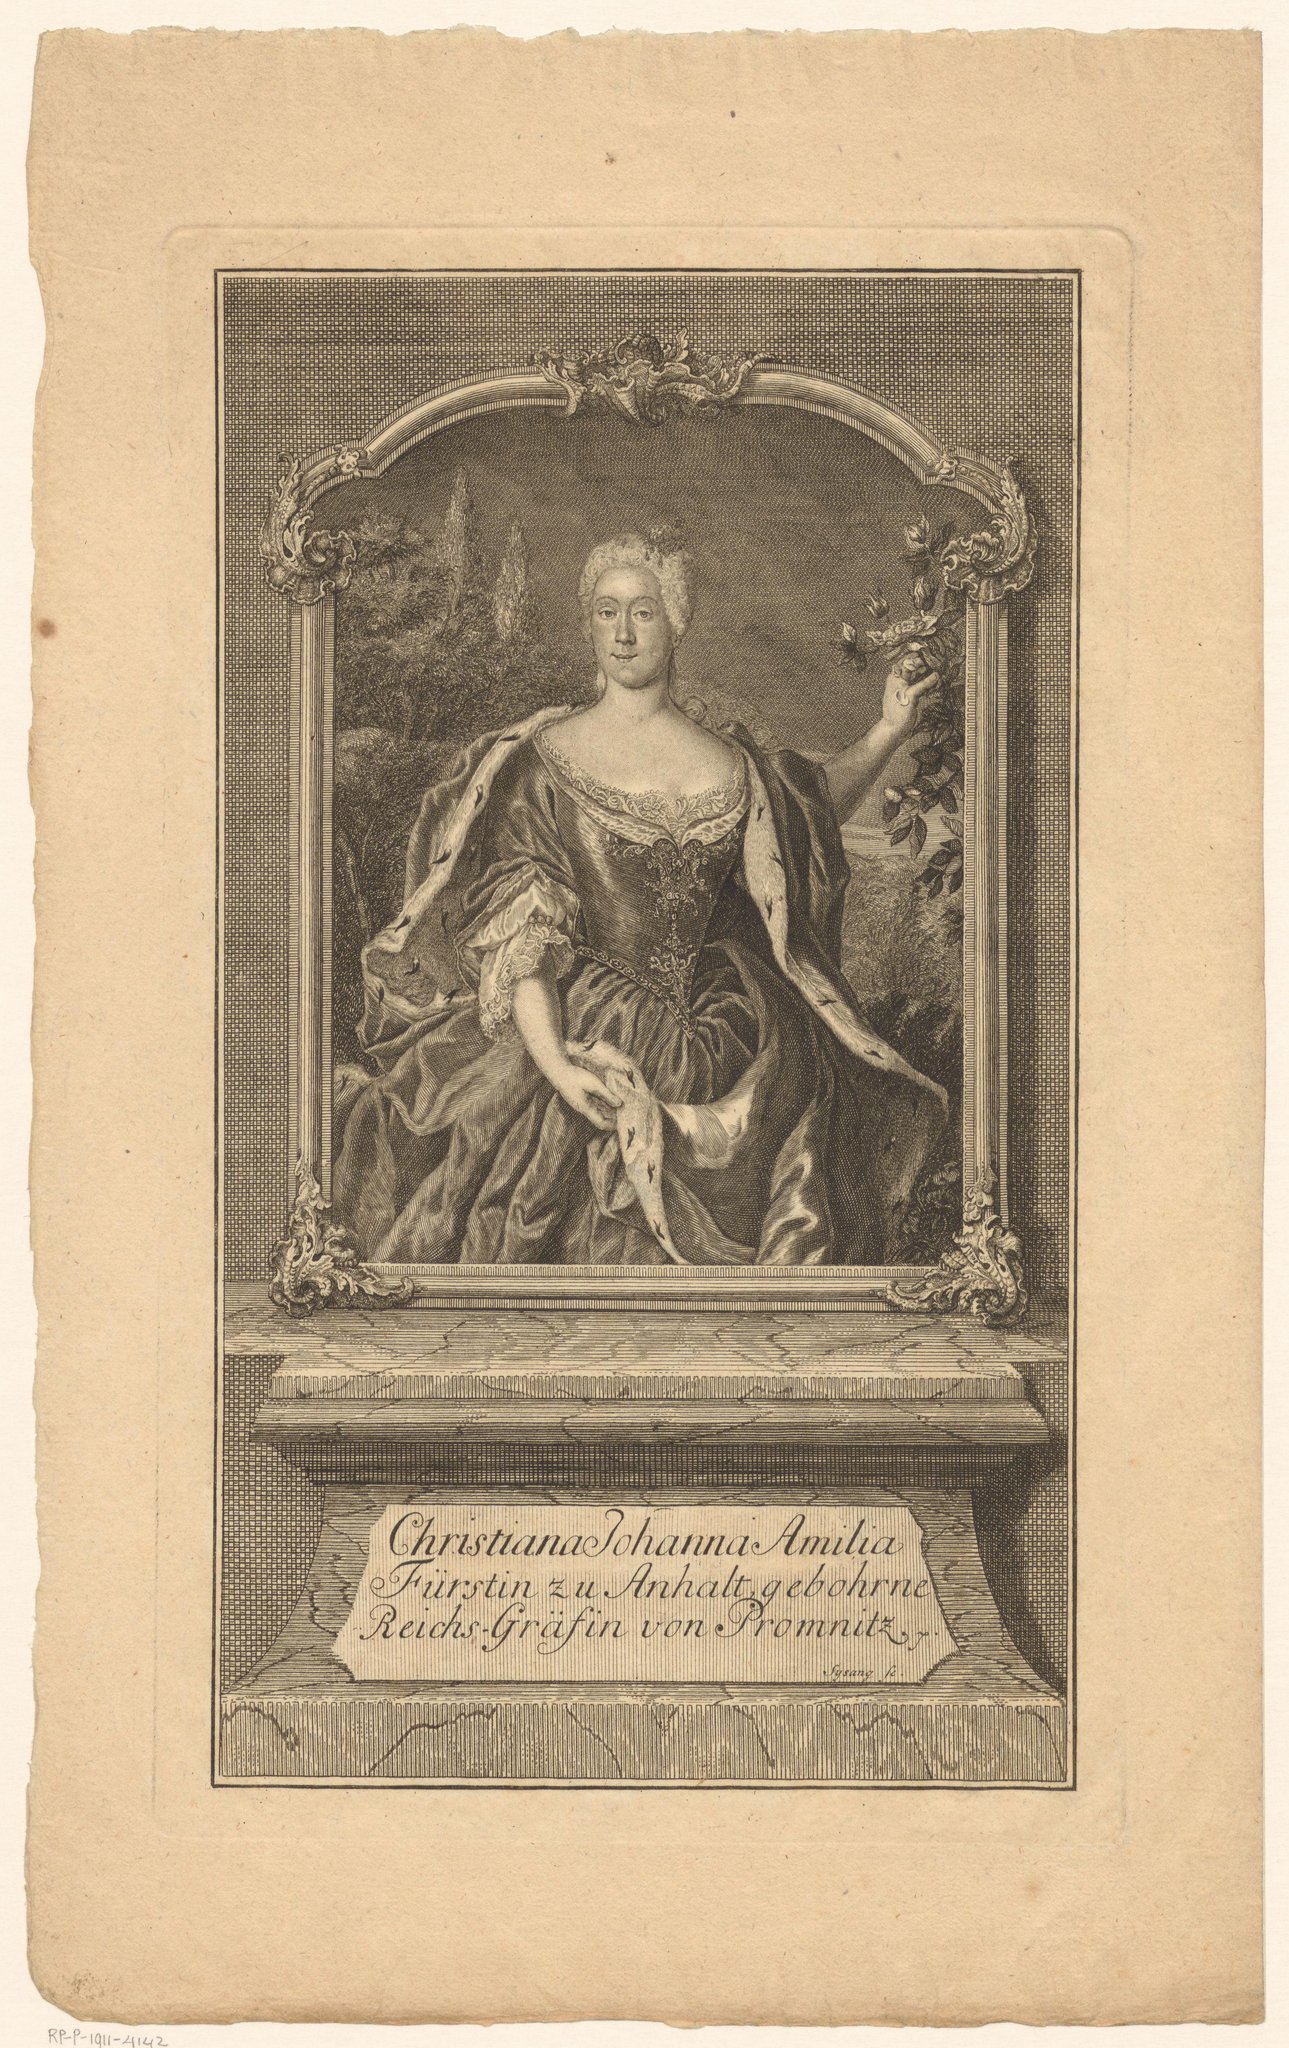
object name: print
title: Portret van Christine Johanna Ämilie, Fürstin von Anhalt-Köthen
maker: johann christoph sysang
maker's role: print maker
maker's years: 1703-1757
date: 1726-1757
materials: paper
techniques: engraving, etching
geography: germany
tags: historical persons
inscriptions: collector's mark: Lugt 2228